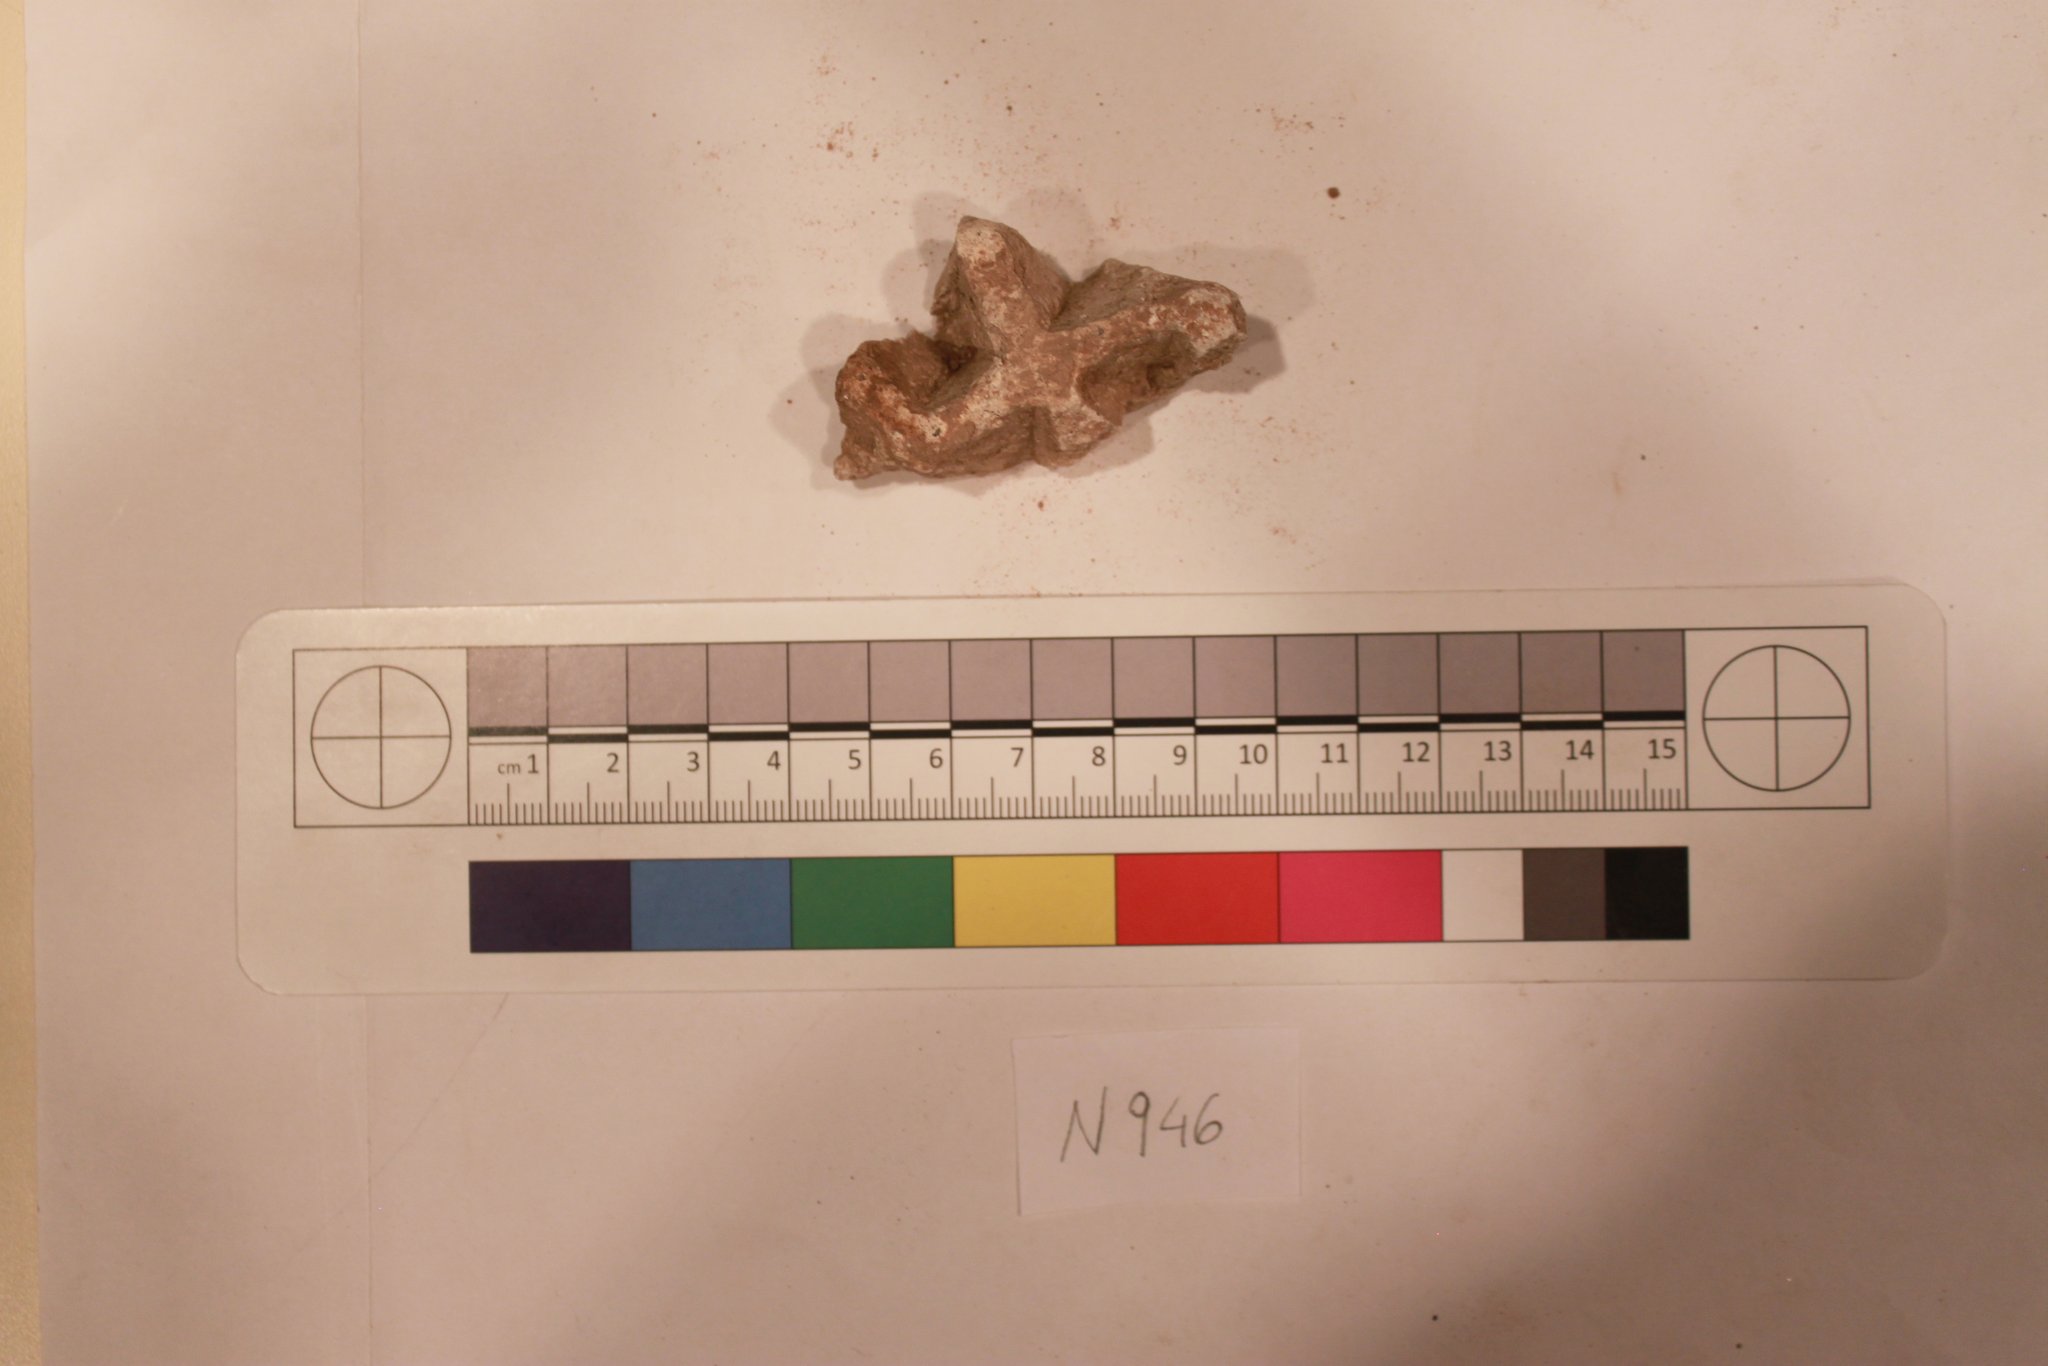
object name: fragment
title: Stucco Fragment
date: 701-1200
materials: plaster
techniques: carving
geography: iran